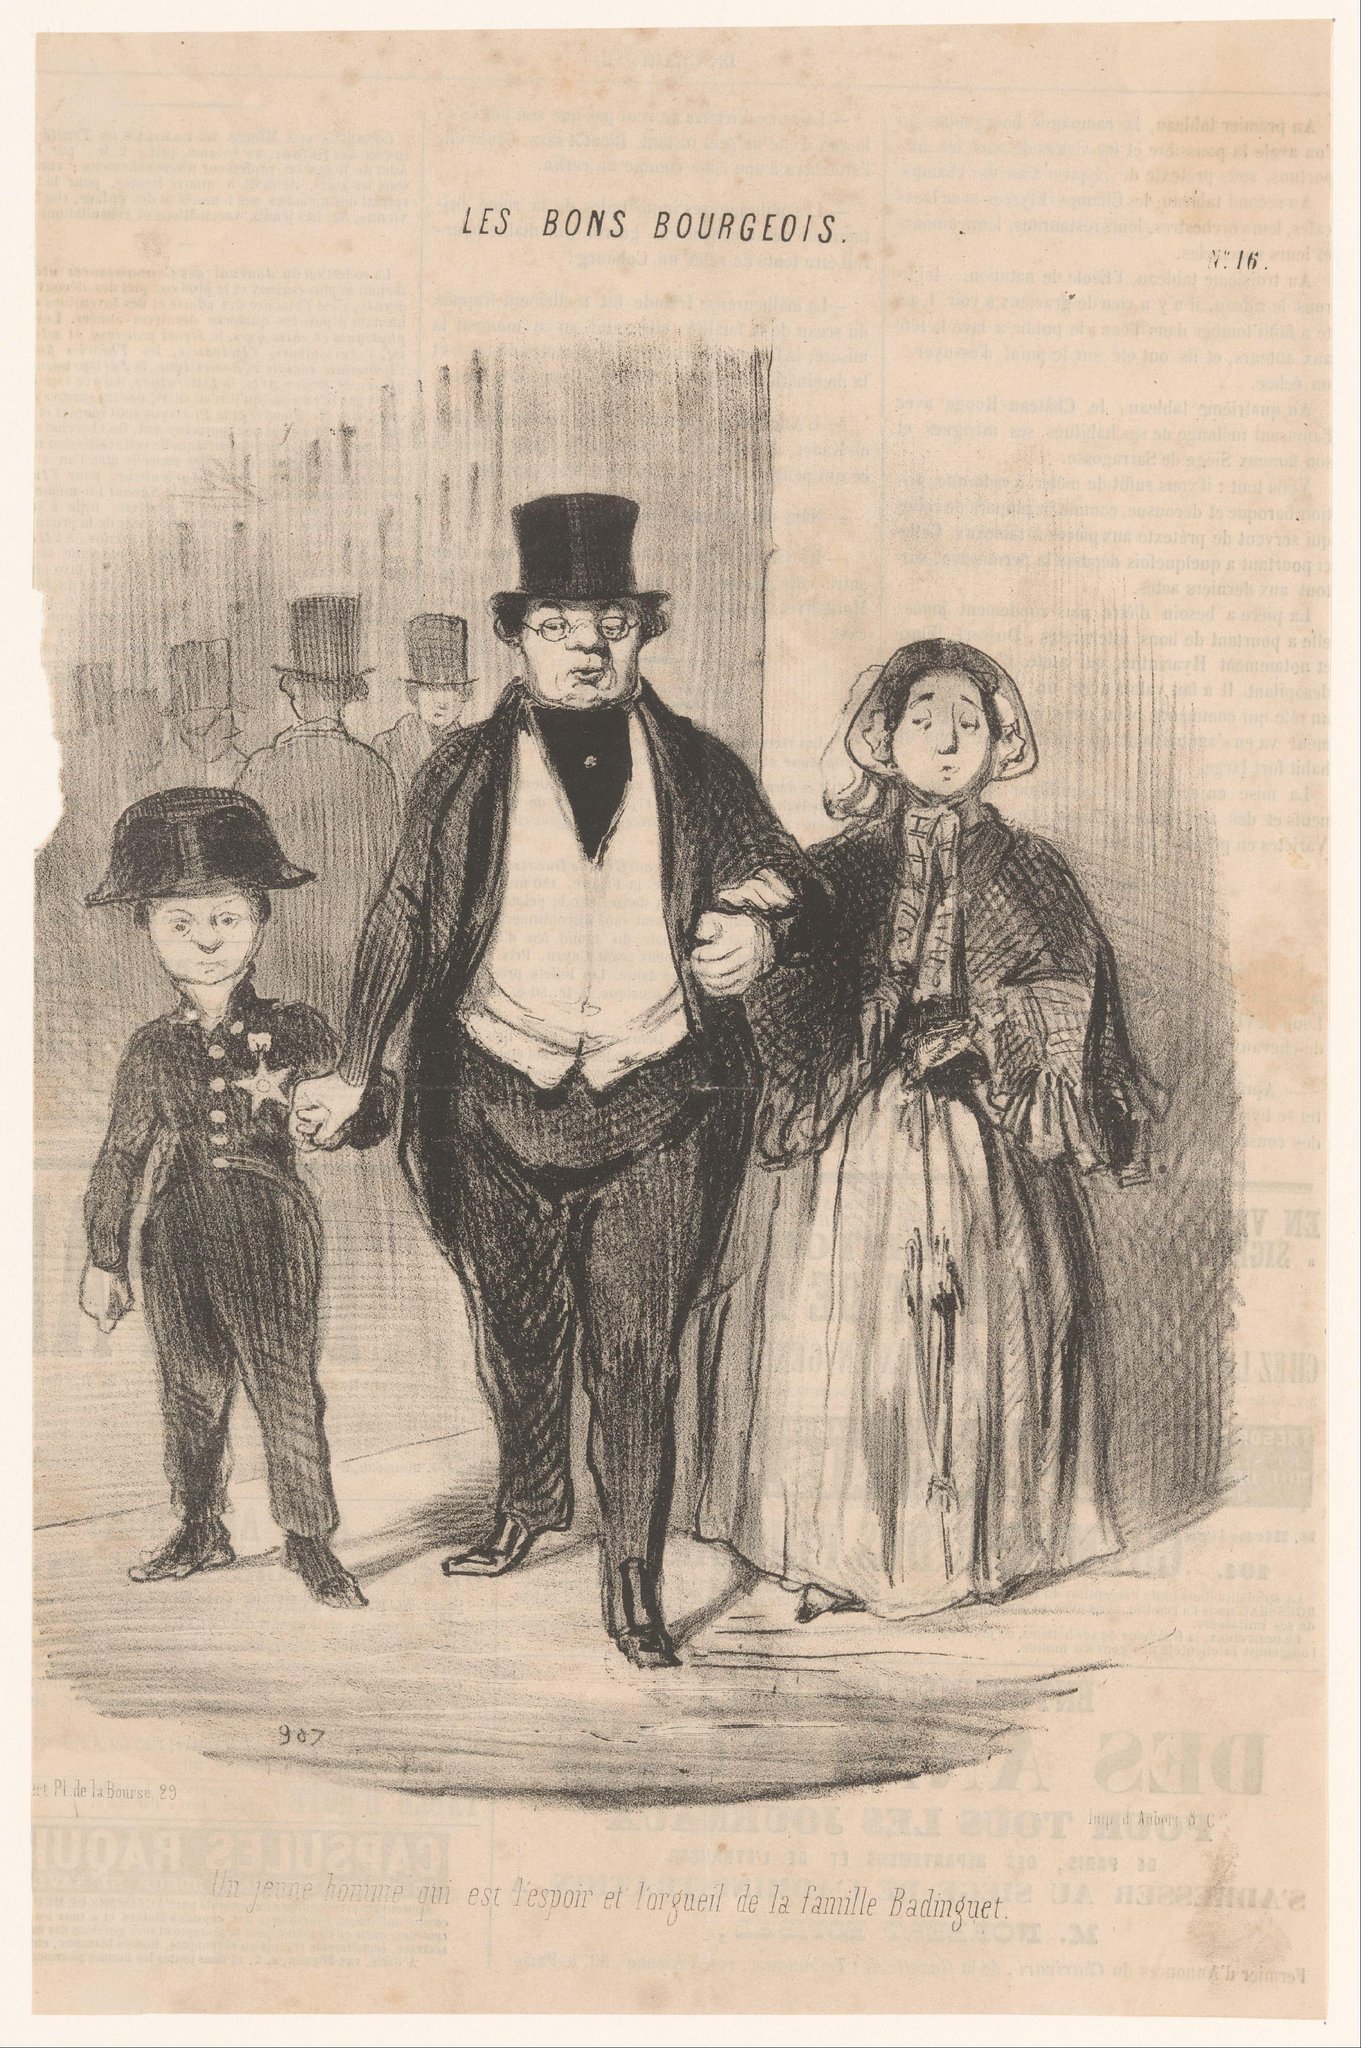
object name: cartoon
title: Goede burgers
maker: honoré daumier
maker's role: draughtsman, painter, print maker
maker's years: 1808-1879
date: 1846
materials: paper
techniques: lithograph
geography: paris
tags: caricatures (human types), boy (child between toddler and youth), parental love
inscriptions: collector's mark: Lugt 2228a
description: Prent gebruikt voor: Le Charivari, 16-09-1846.